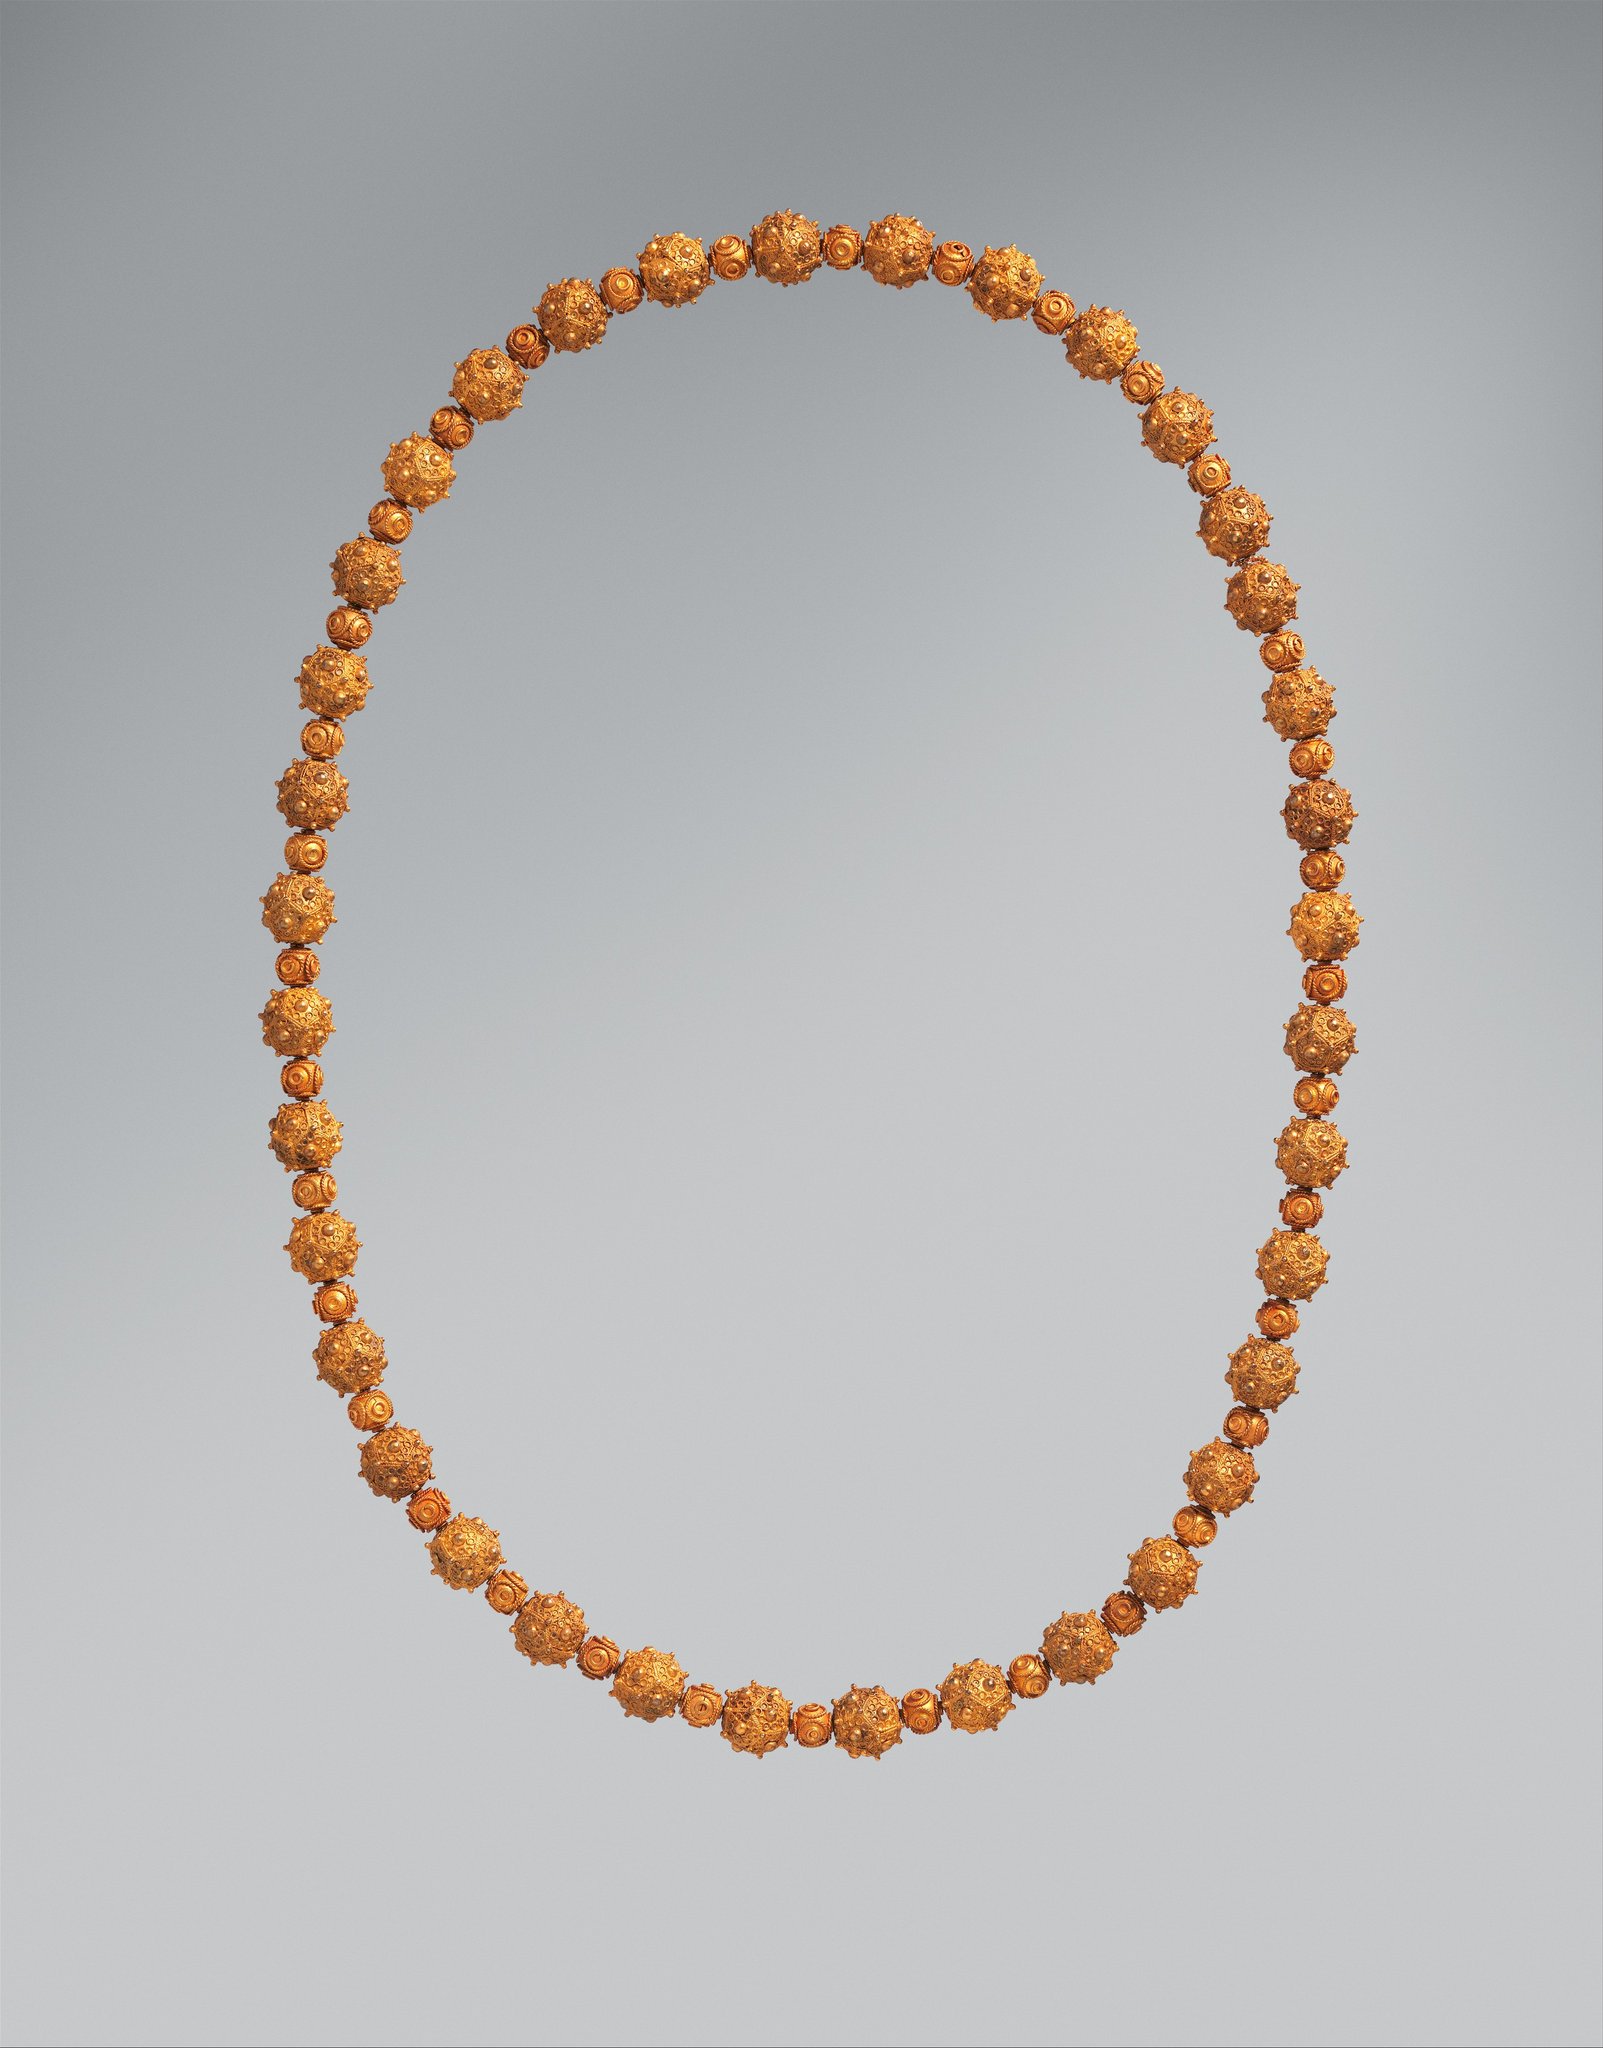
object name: necklace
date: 1101-1300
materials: gold, metal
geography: iran